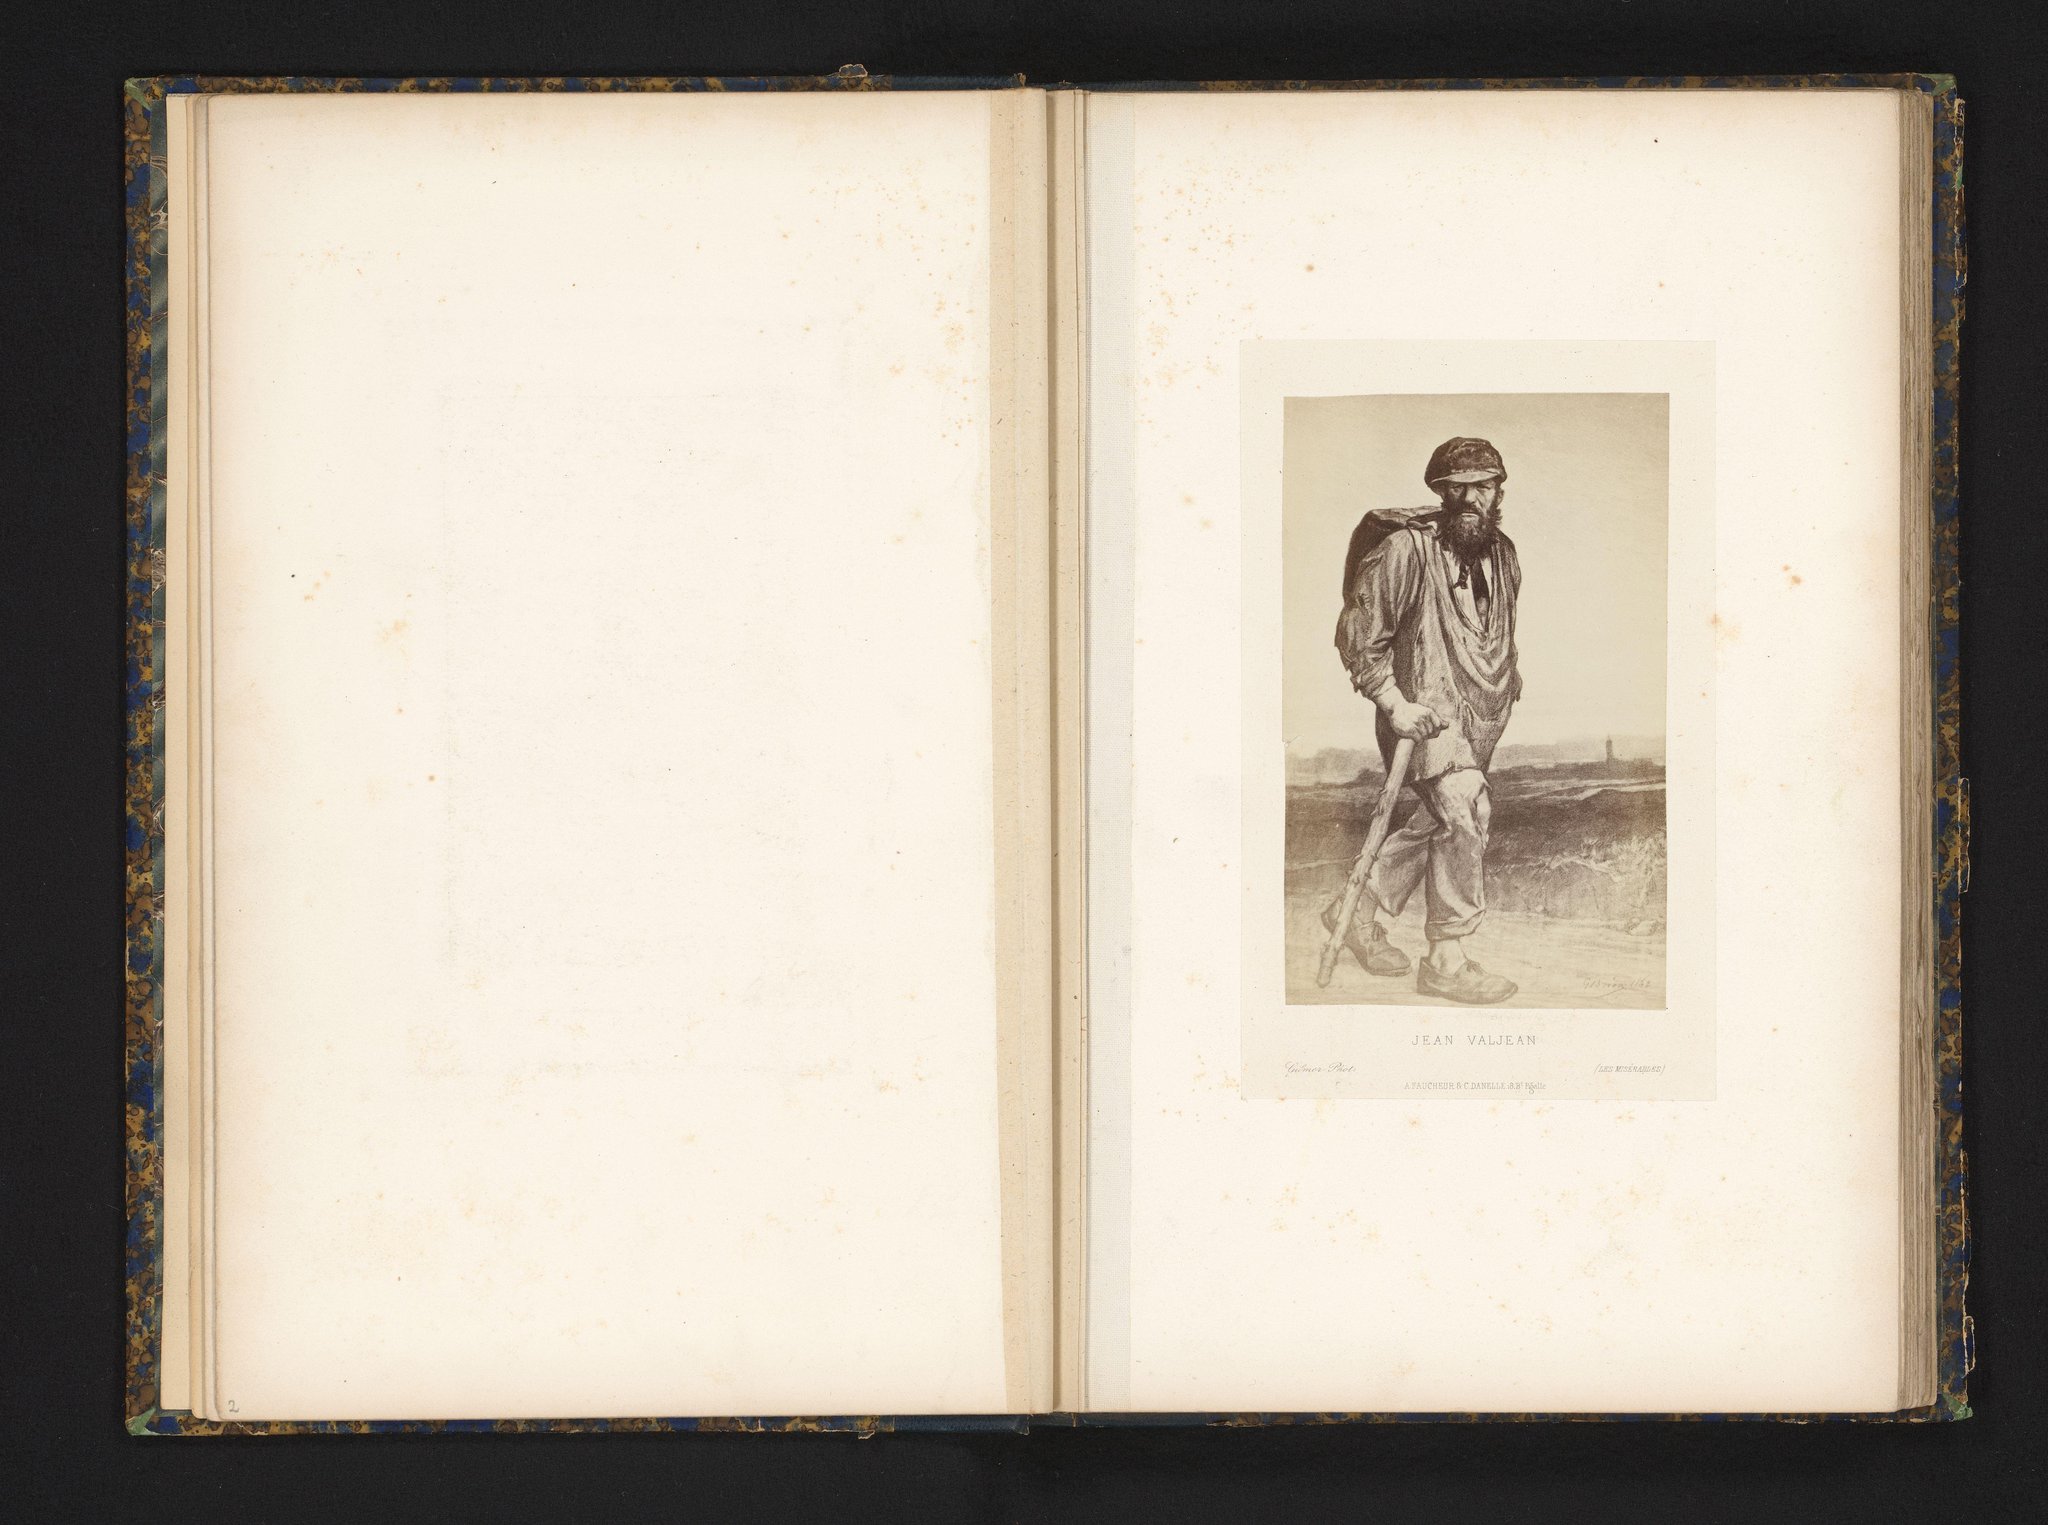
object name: reproduction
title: Jean Valjean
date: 1862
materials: photographic support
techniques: albumen print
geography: paris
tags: literary characters and objects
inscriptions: address: ‘A. FAUCHEUR & C. DANELLE 18, Bt. Pigalle.’, inscription: ‘(LES MISÉRABLES)’